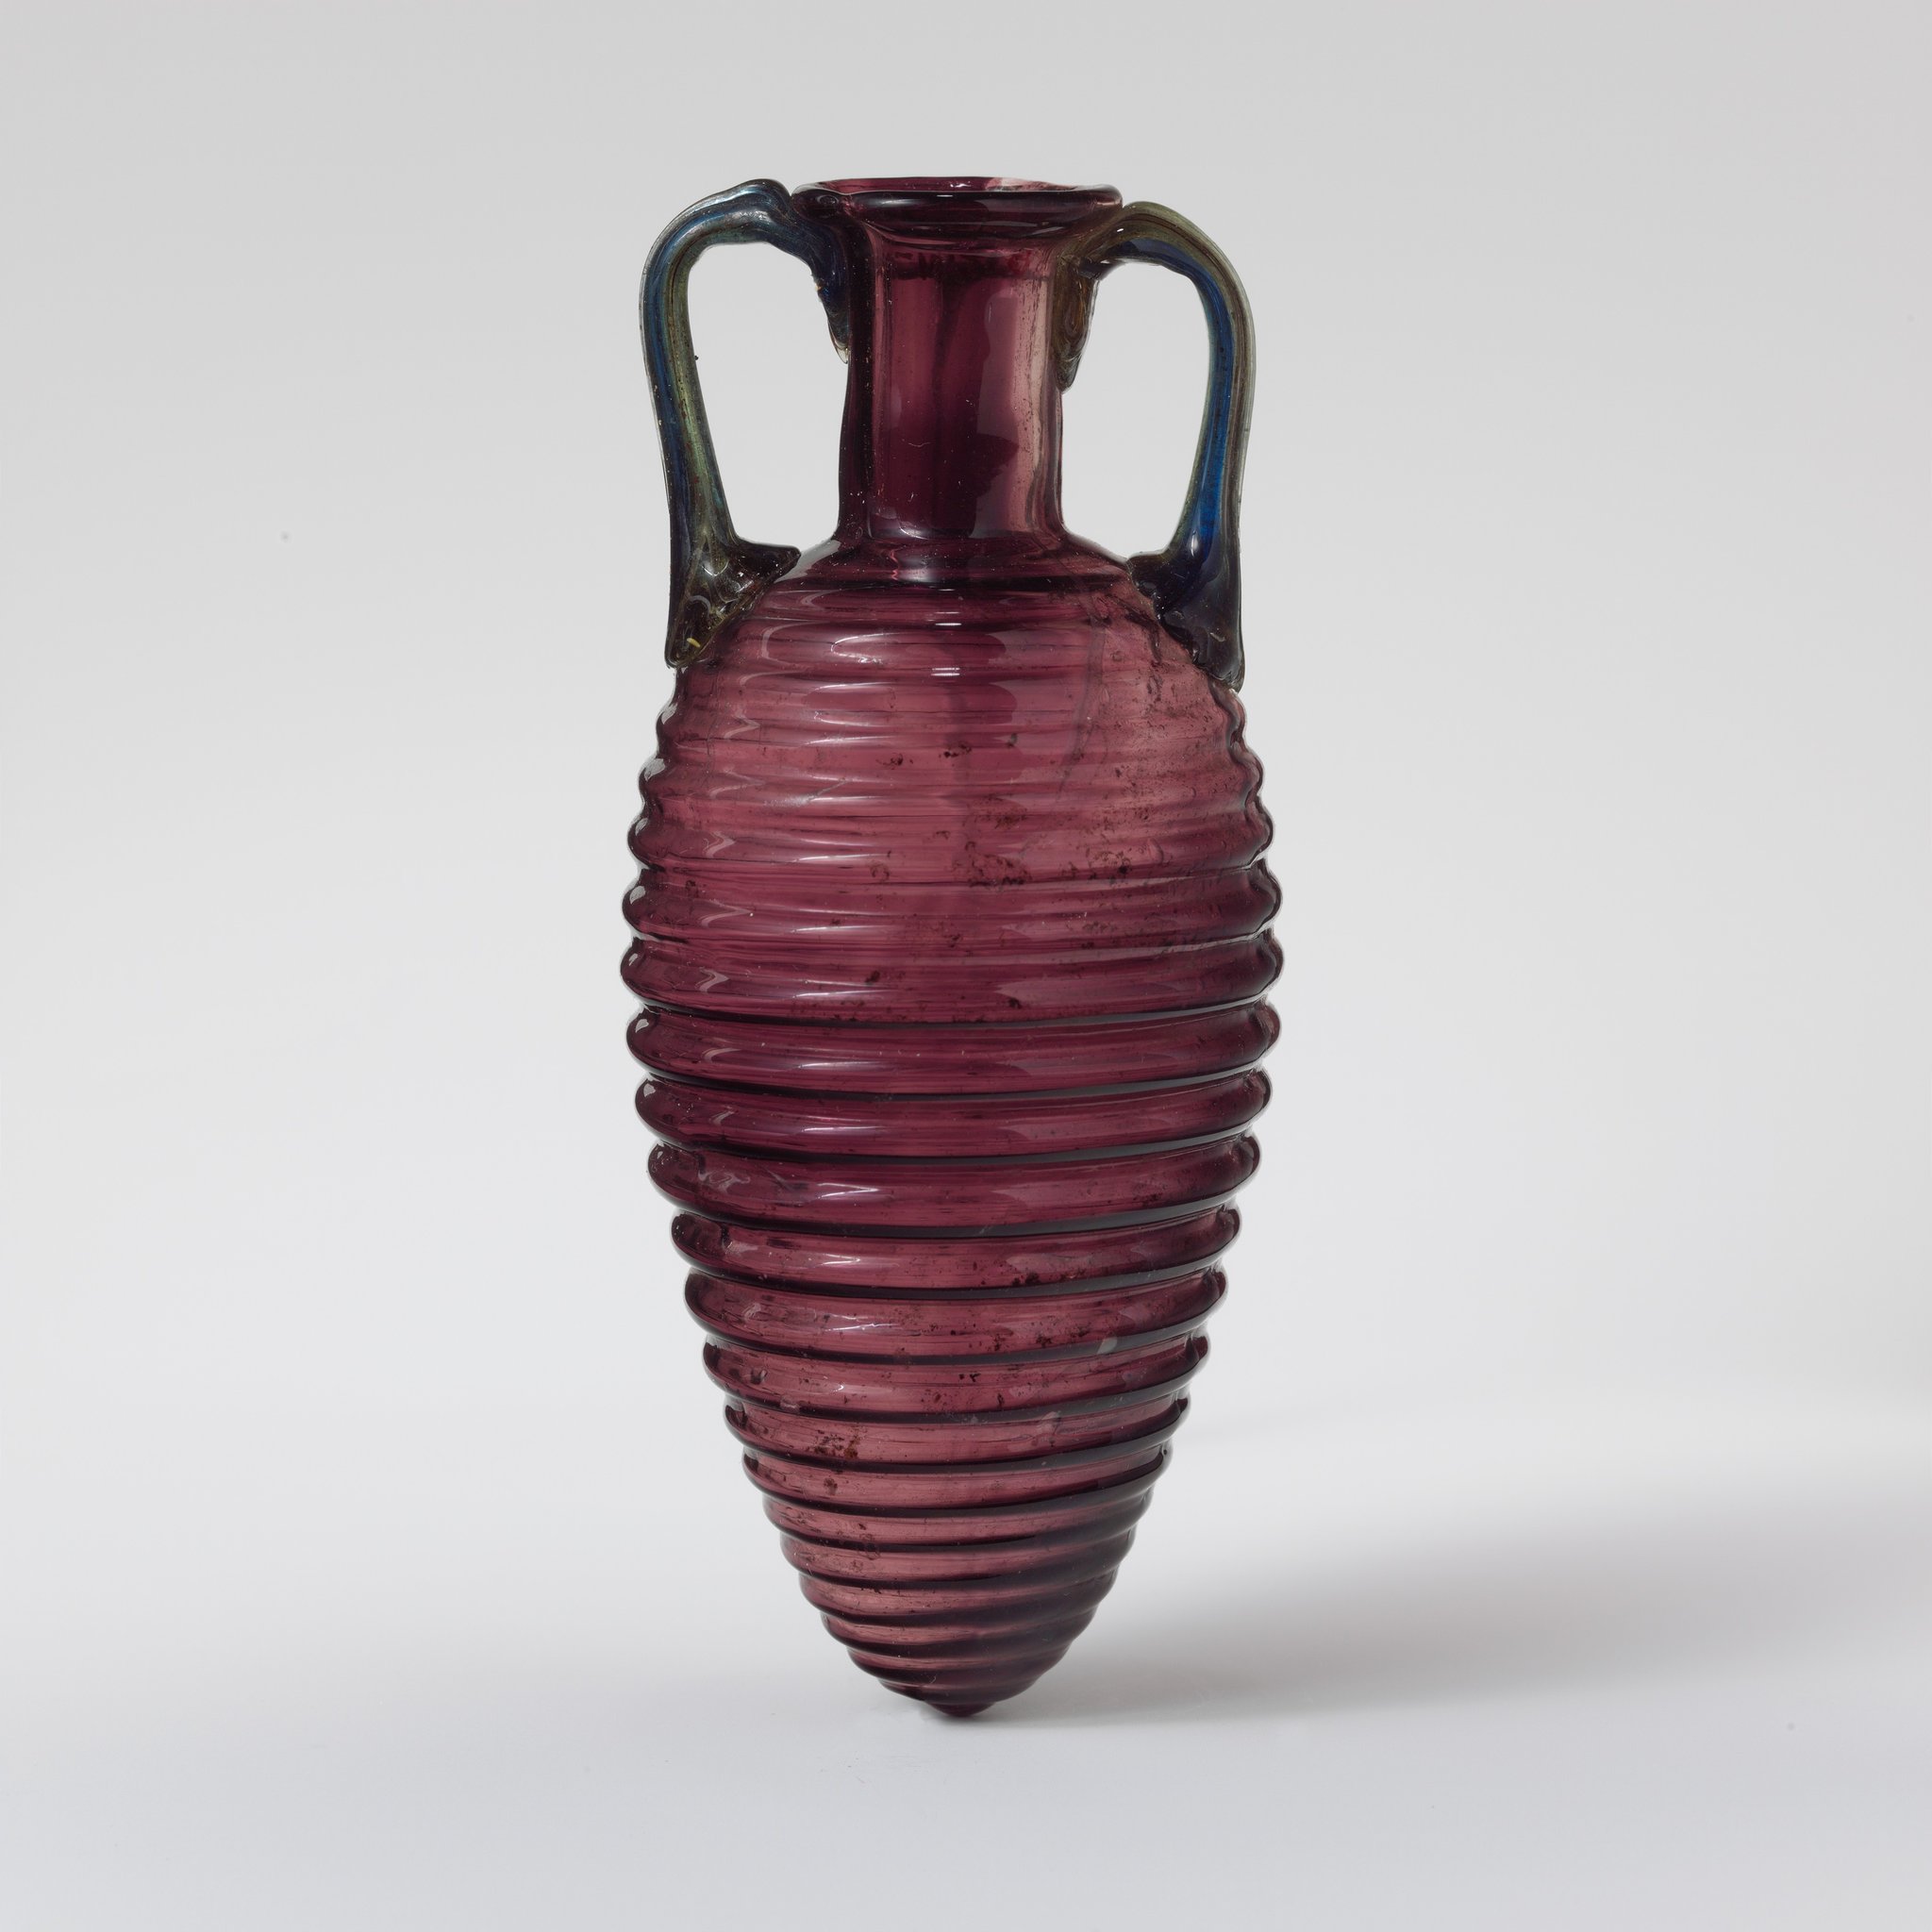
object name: miniature transport amphora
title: Glass amphoriskos with horizontal ribs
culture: roman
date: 51-100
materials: glass